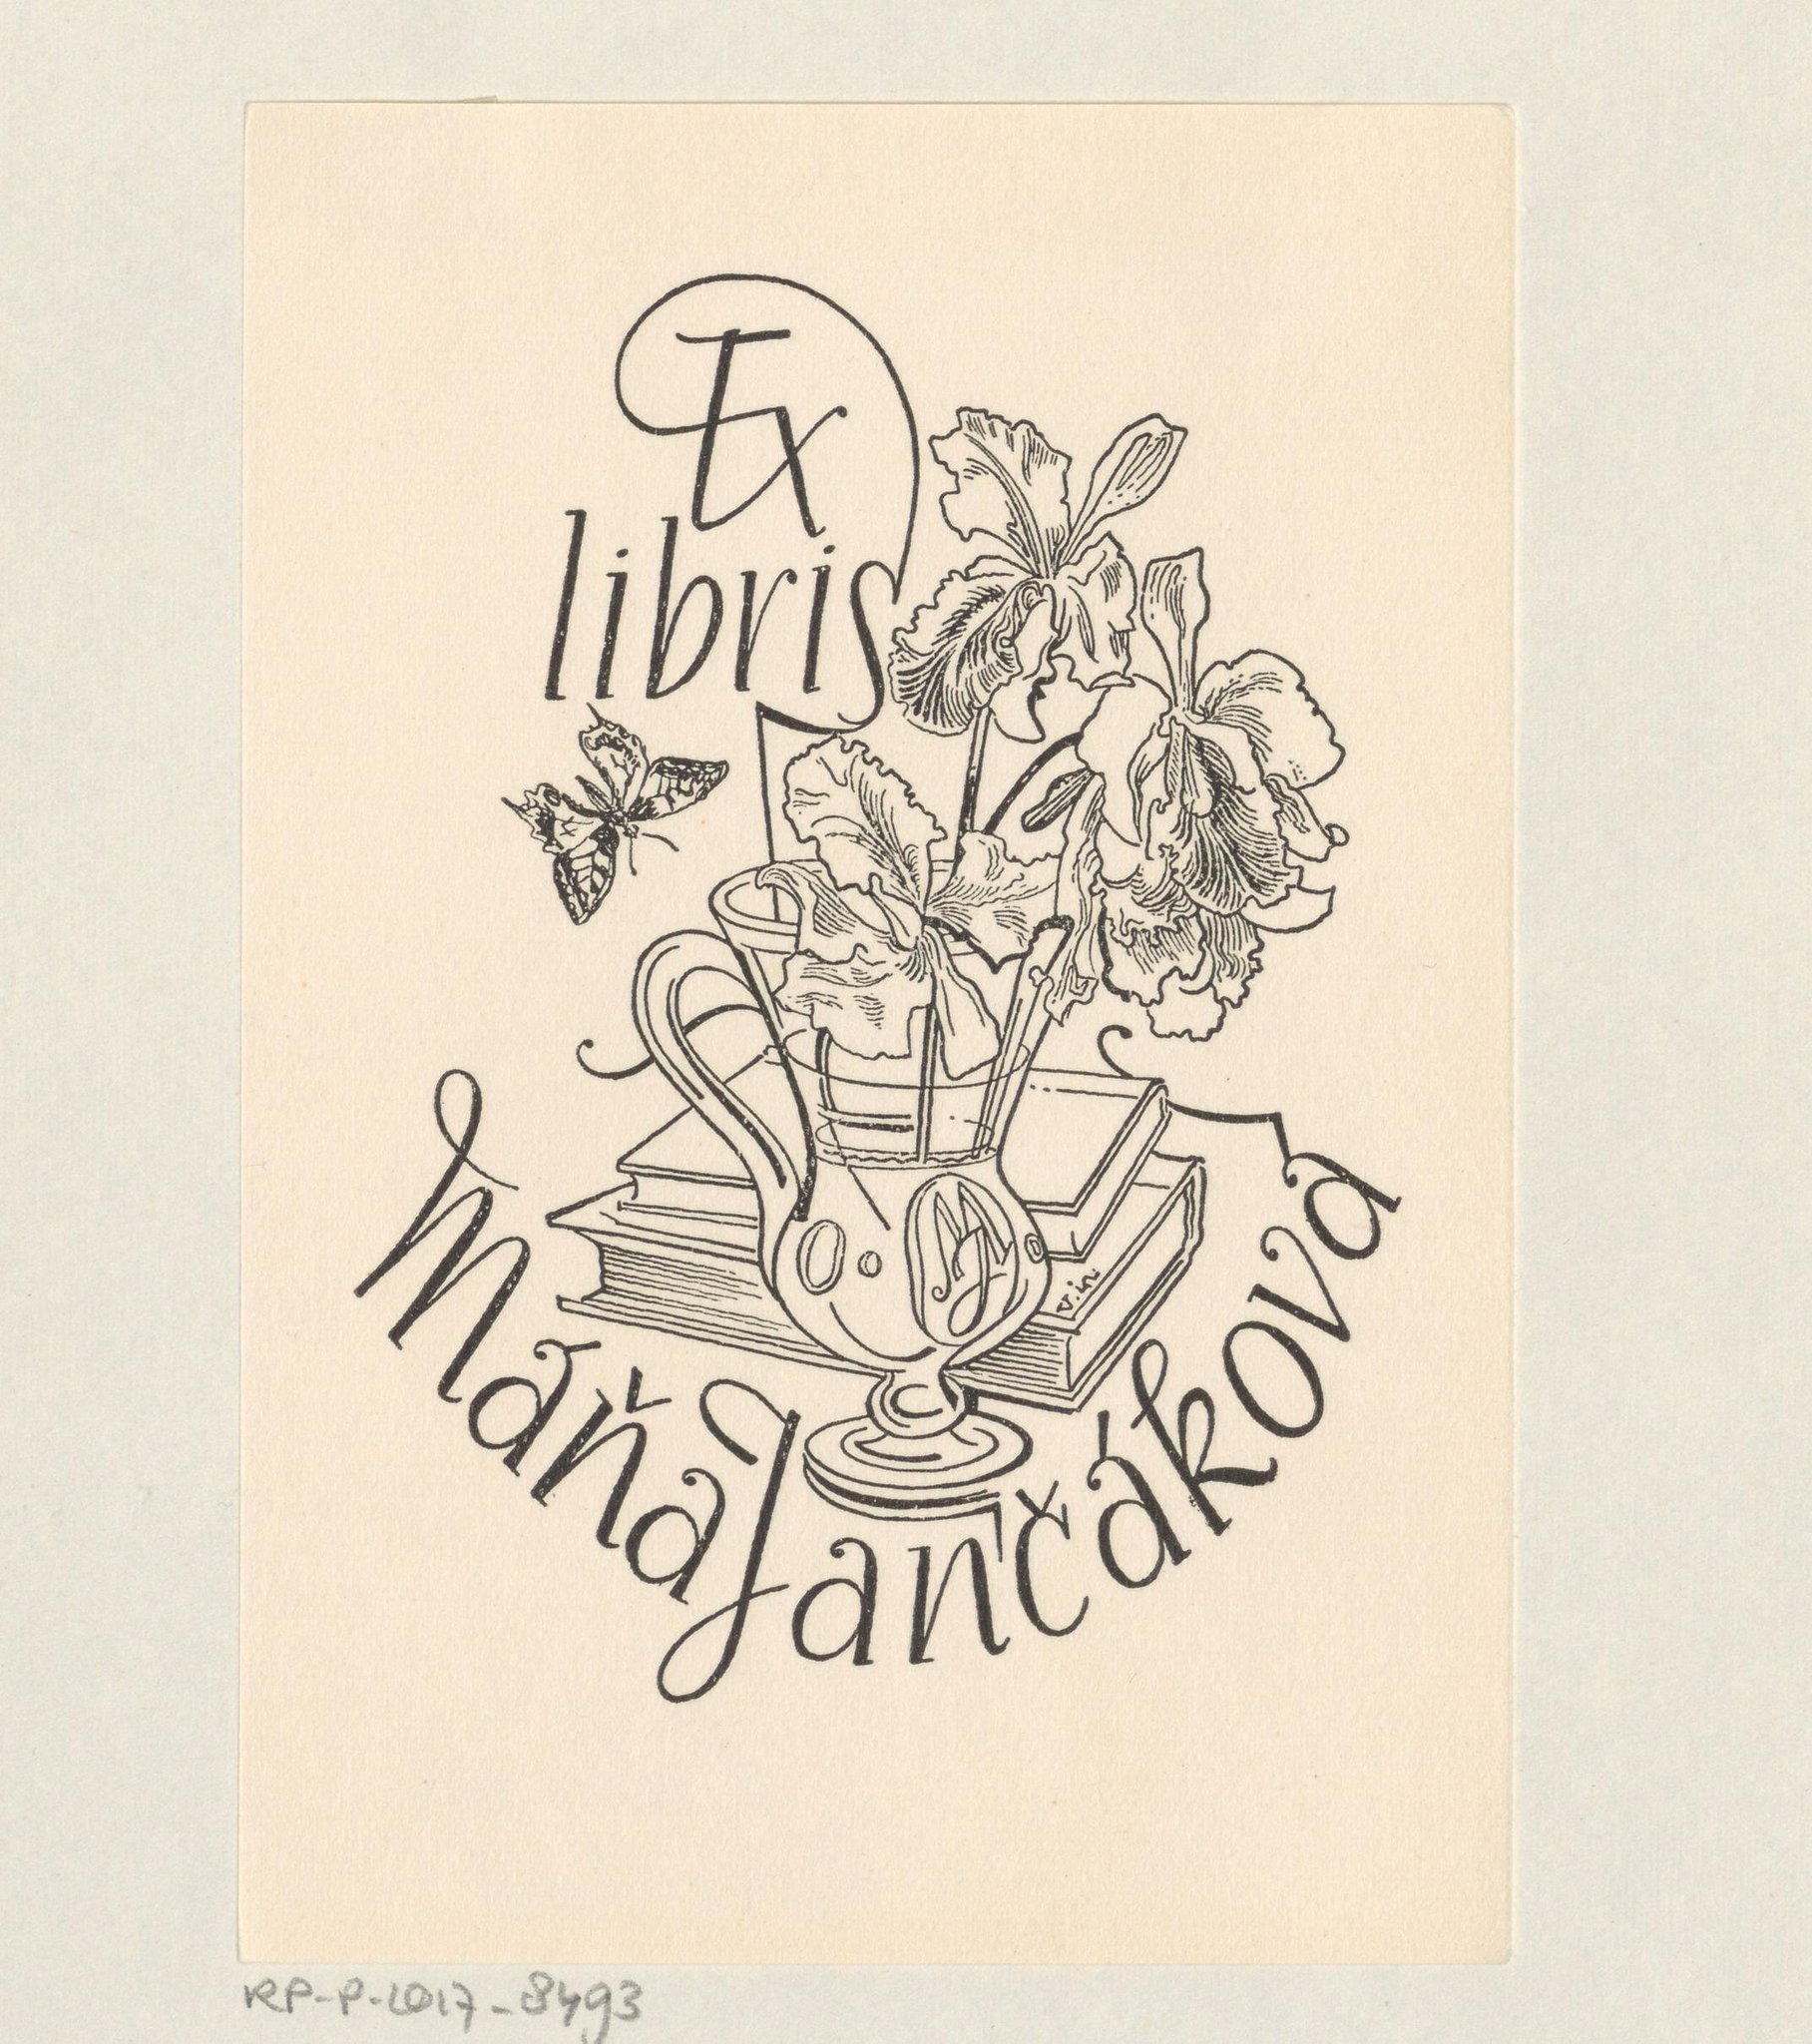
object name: bookplate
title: Ex libris van Máňa Jančáková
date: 1900-1999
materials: paper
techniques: printing block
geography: czech republic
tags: standing figure - aa - female human figure, flowers: iris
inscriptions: inscription: ‘Vozlueki [?]’